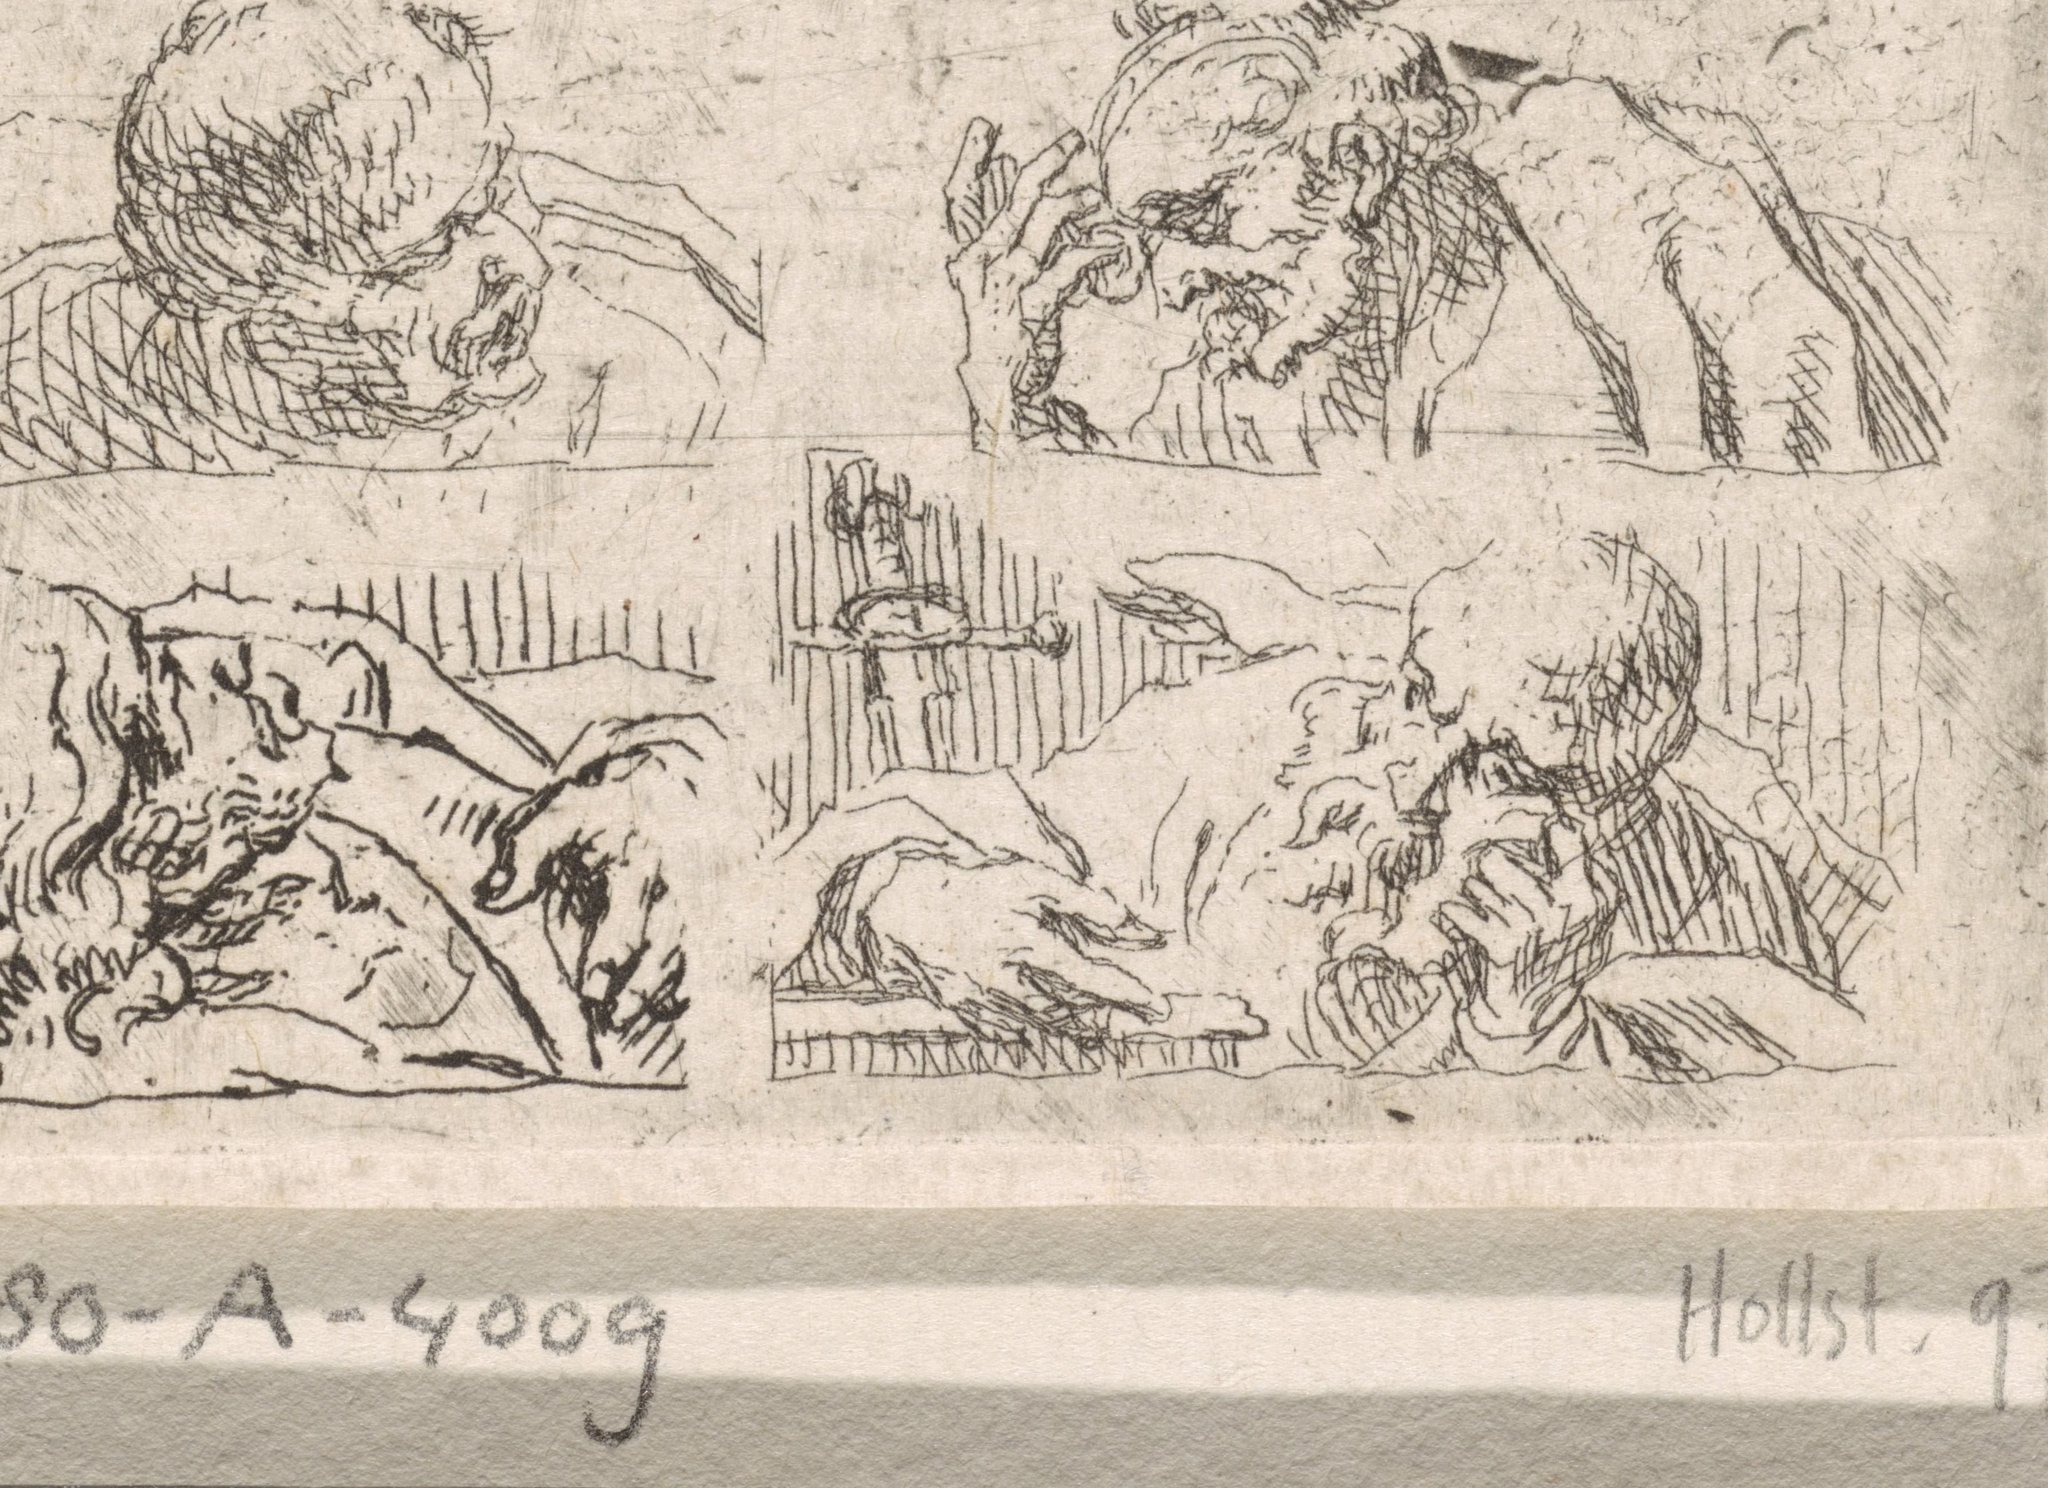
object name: print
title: Zes studies van hoofden van apostelen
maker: cornelis schut (i)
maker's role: draughtsman, print maker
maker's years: 1597-1655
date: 1618-1655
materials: paper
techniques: etching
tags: (single) apostle, unspecified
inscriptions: collector's mark: Lugt 2228